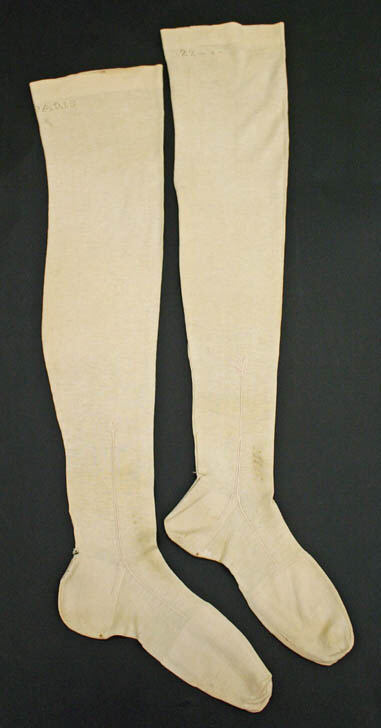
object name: stocking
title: Stockings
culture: french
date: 1870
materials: cotton